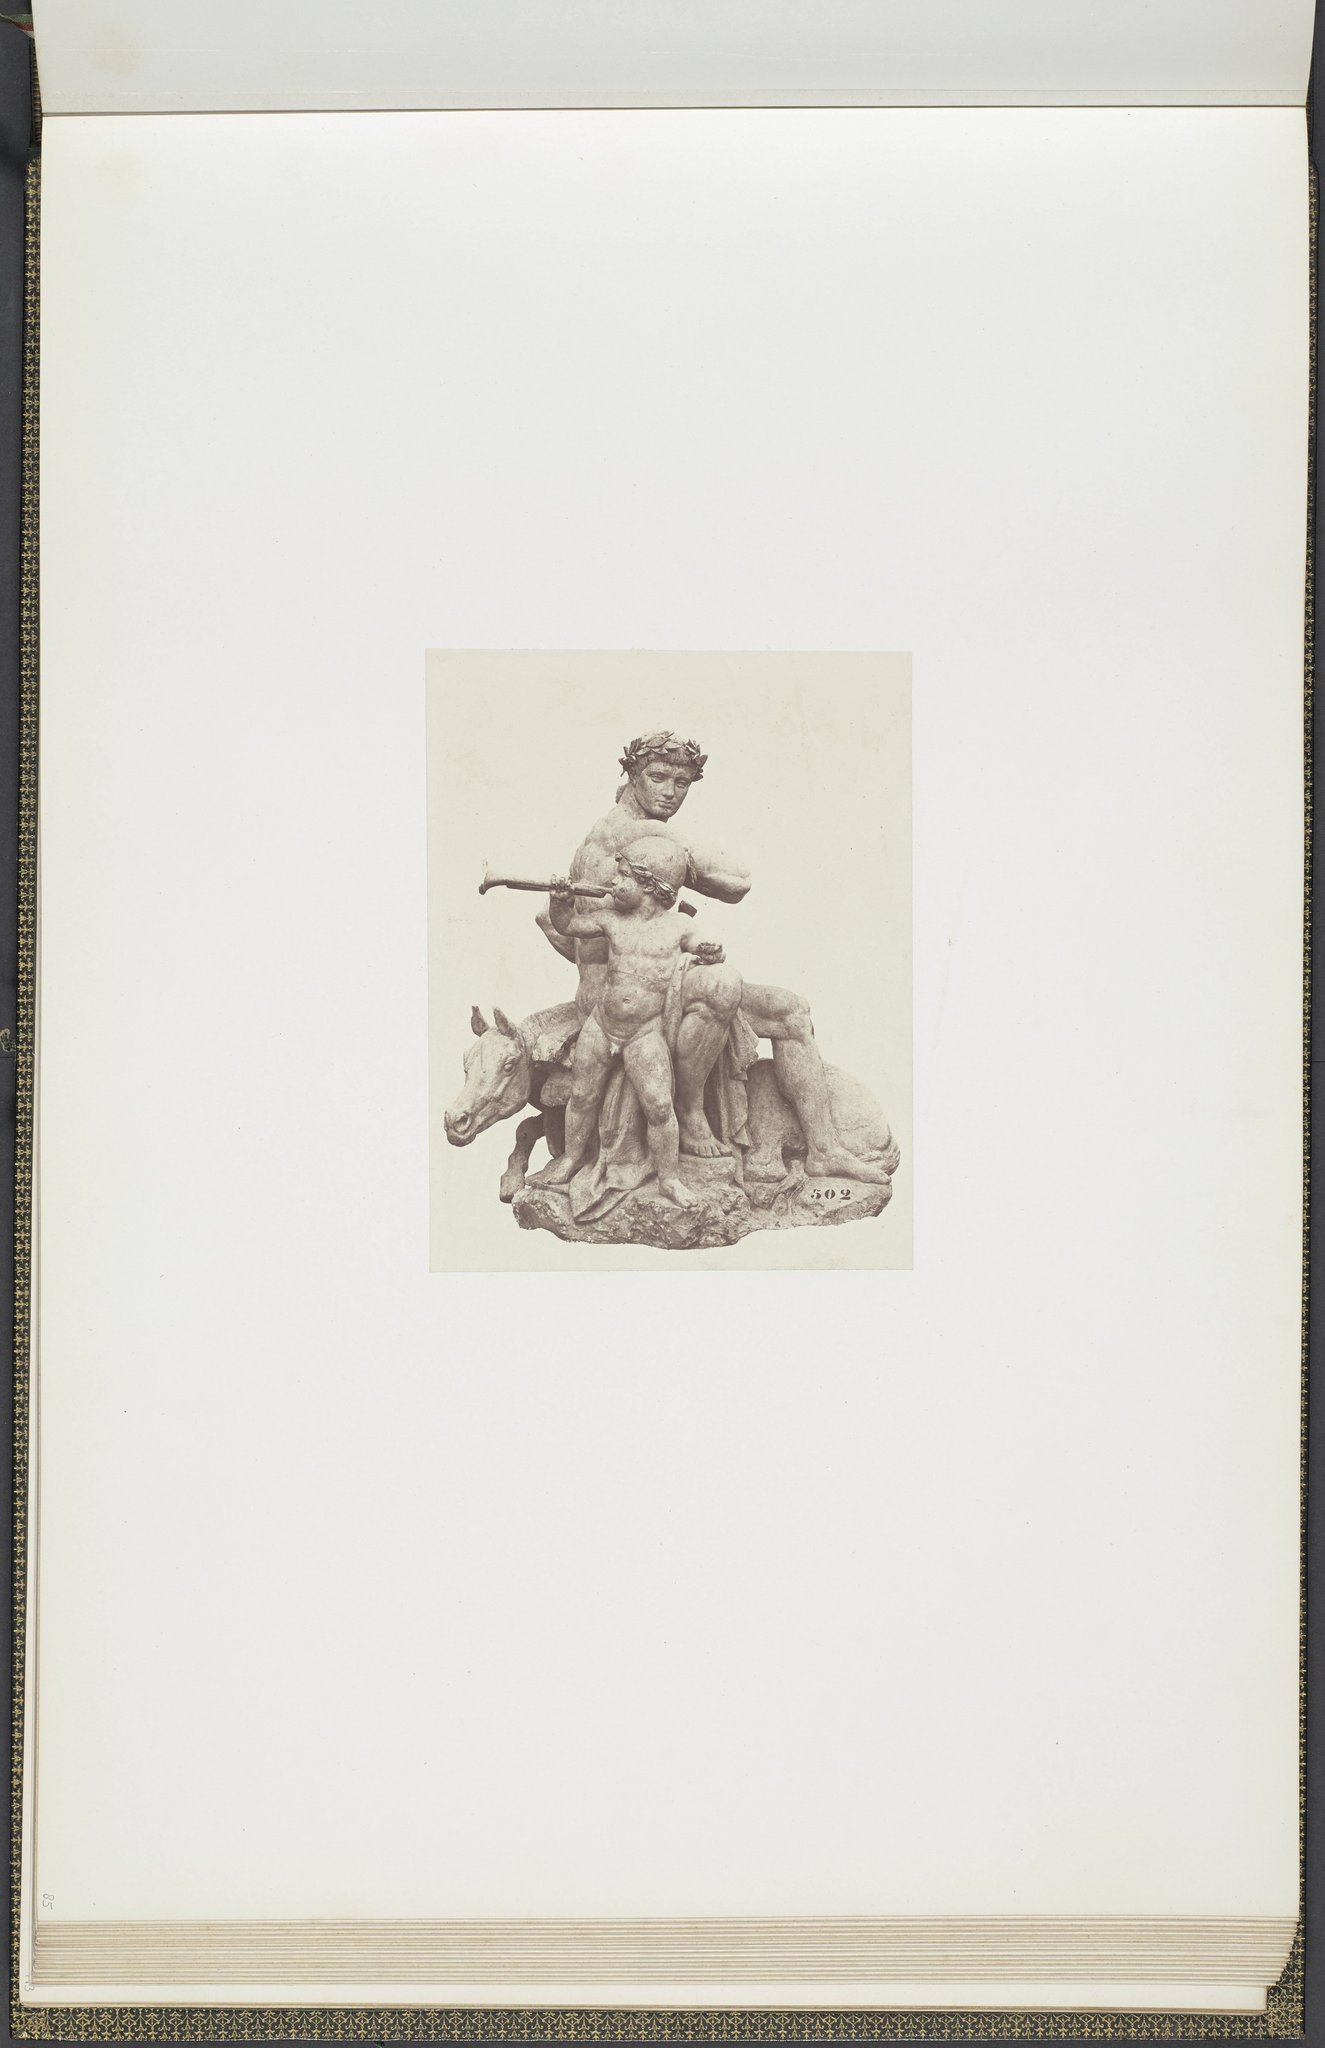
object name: album leaf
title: Gipsmodel voor beeldhouwwerk op het Palais du Louvre: "La Victoire" door Antoine-Louis Barye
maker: édouard denis baldus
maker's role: fotograaf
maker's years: 1813-1889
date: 1855-1857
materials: paper, photographic support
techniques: salted paper print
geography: paris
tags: piece of sculpture, reproduction of a piece of sculpture, permanent exhibition, museum, paris, tuileries palace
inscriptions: number: ‘502’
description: Onderdeel van Réunion des Tuileries au Louvre 1852-1857, album 1.